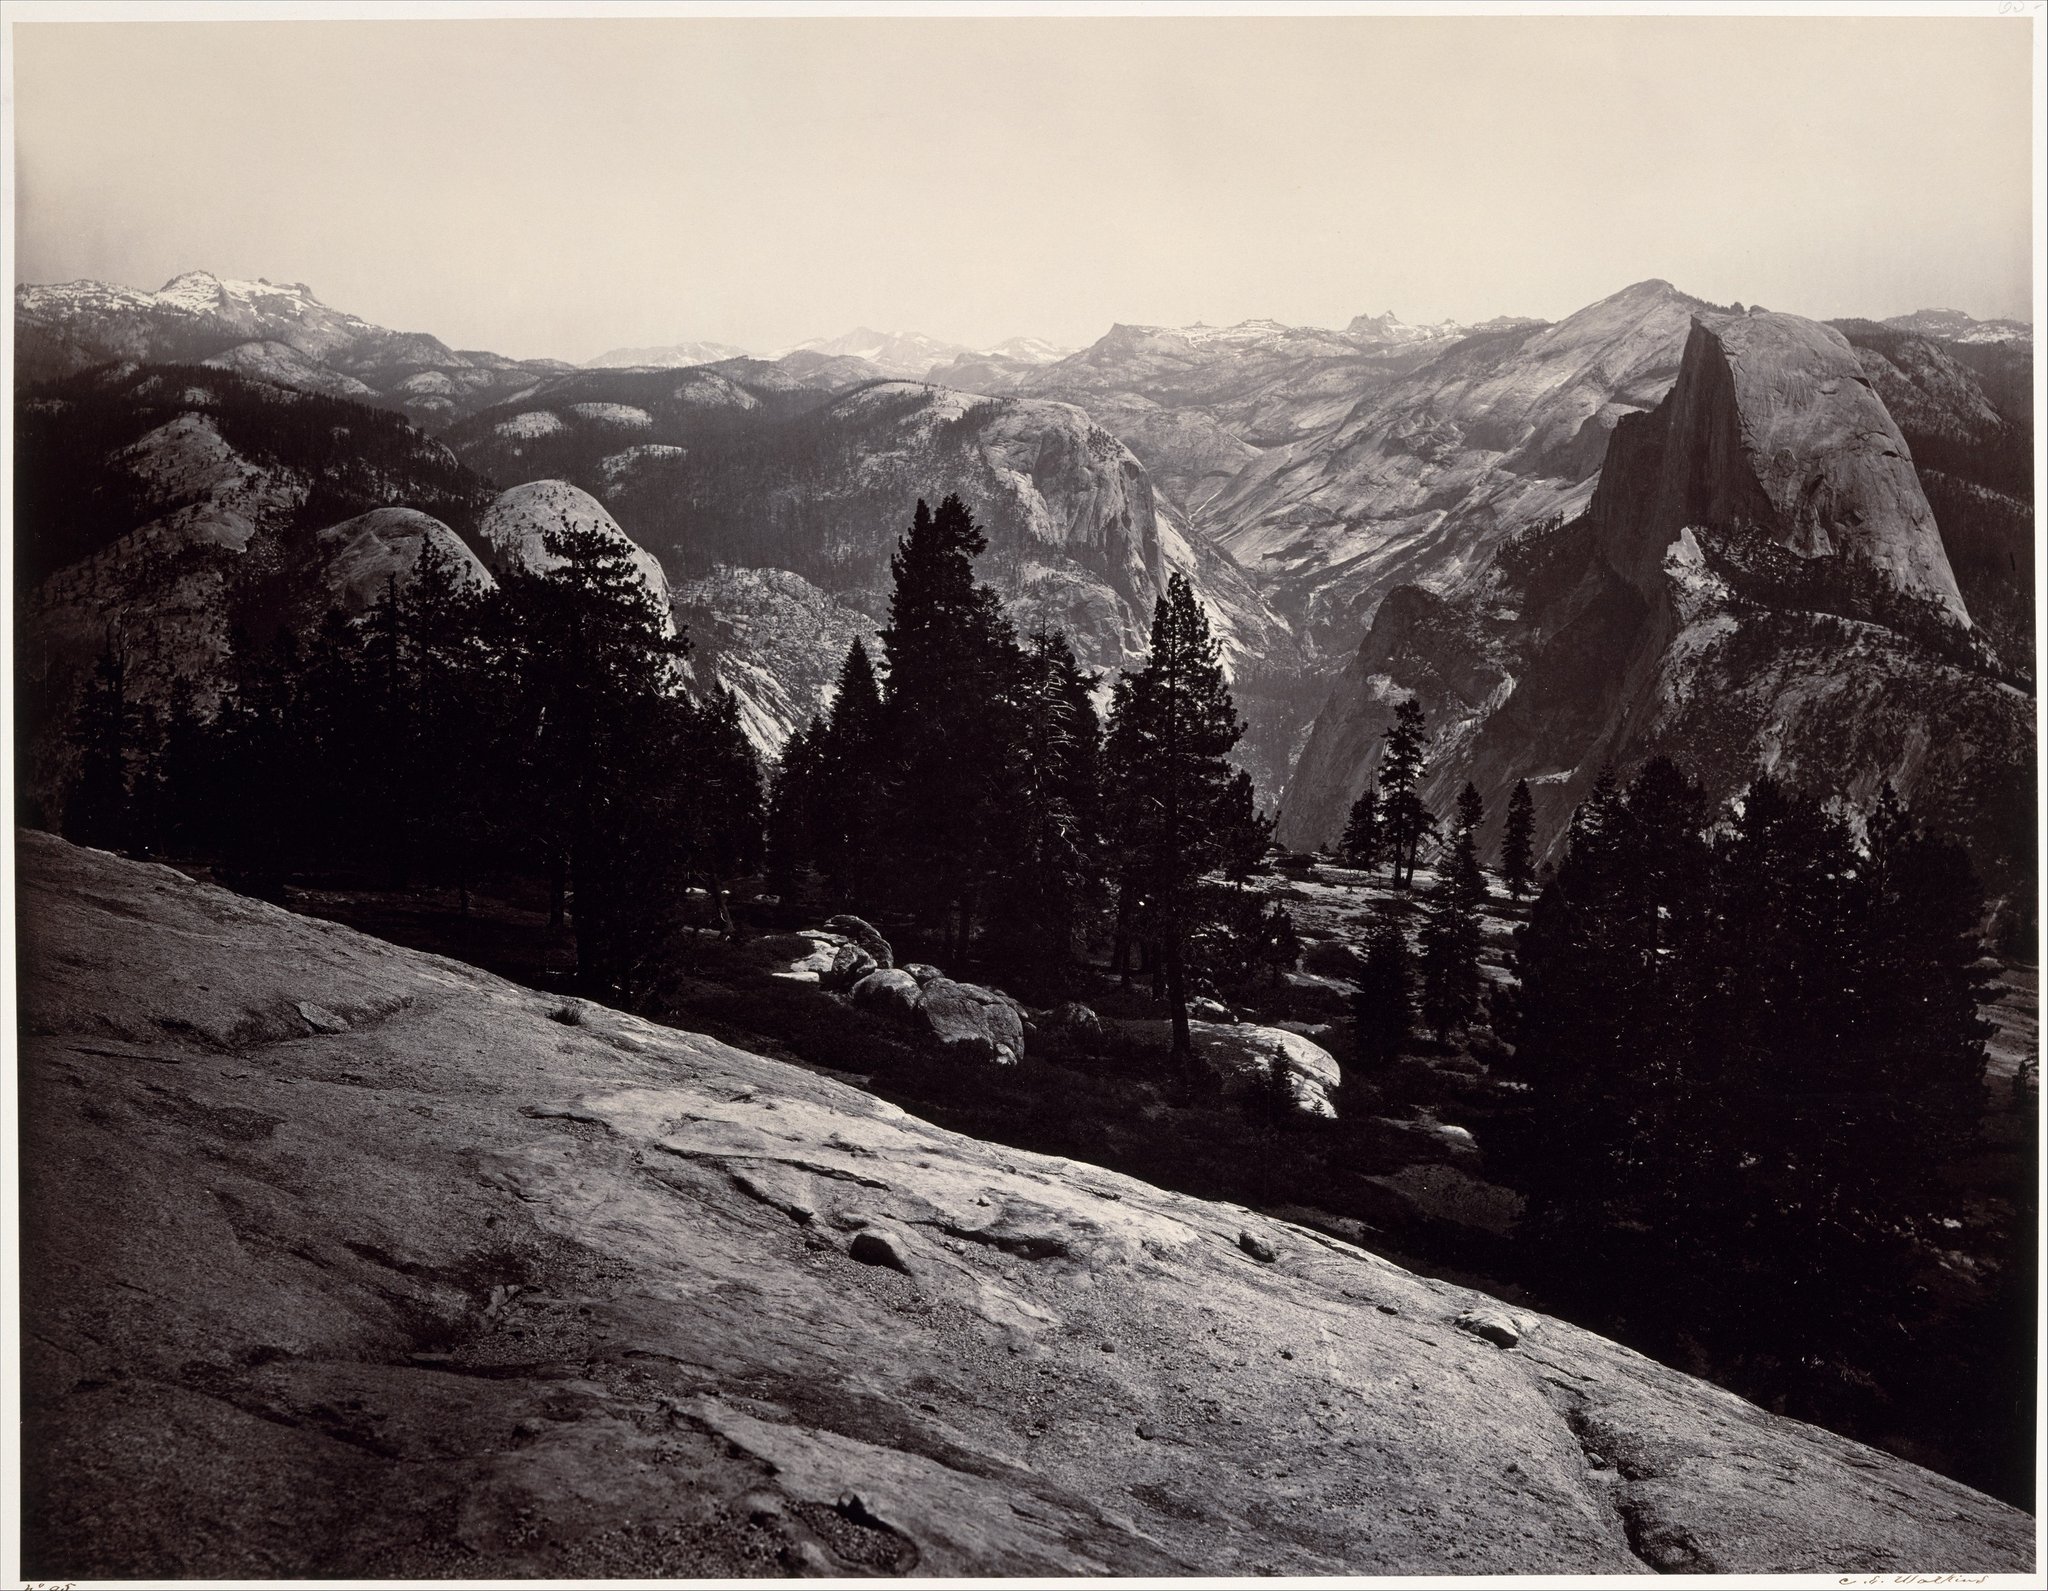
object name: panorama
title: View from the Sentinel Dome, Yosemite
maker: carleton e. watkins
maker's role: artist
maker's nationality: american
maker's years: 1829-1916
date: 1865-1866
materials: glass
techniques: albumen silver print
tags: mountains,landscapes